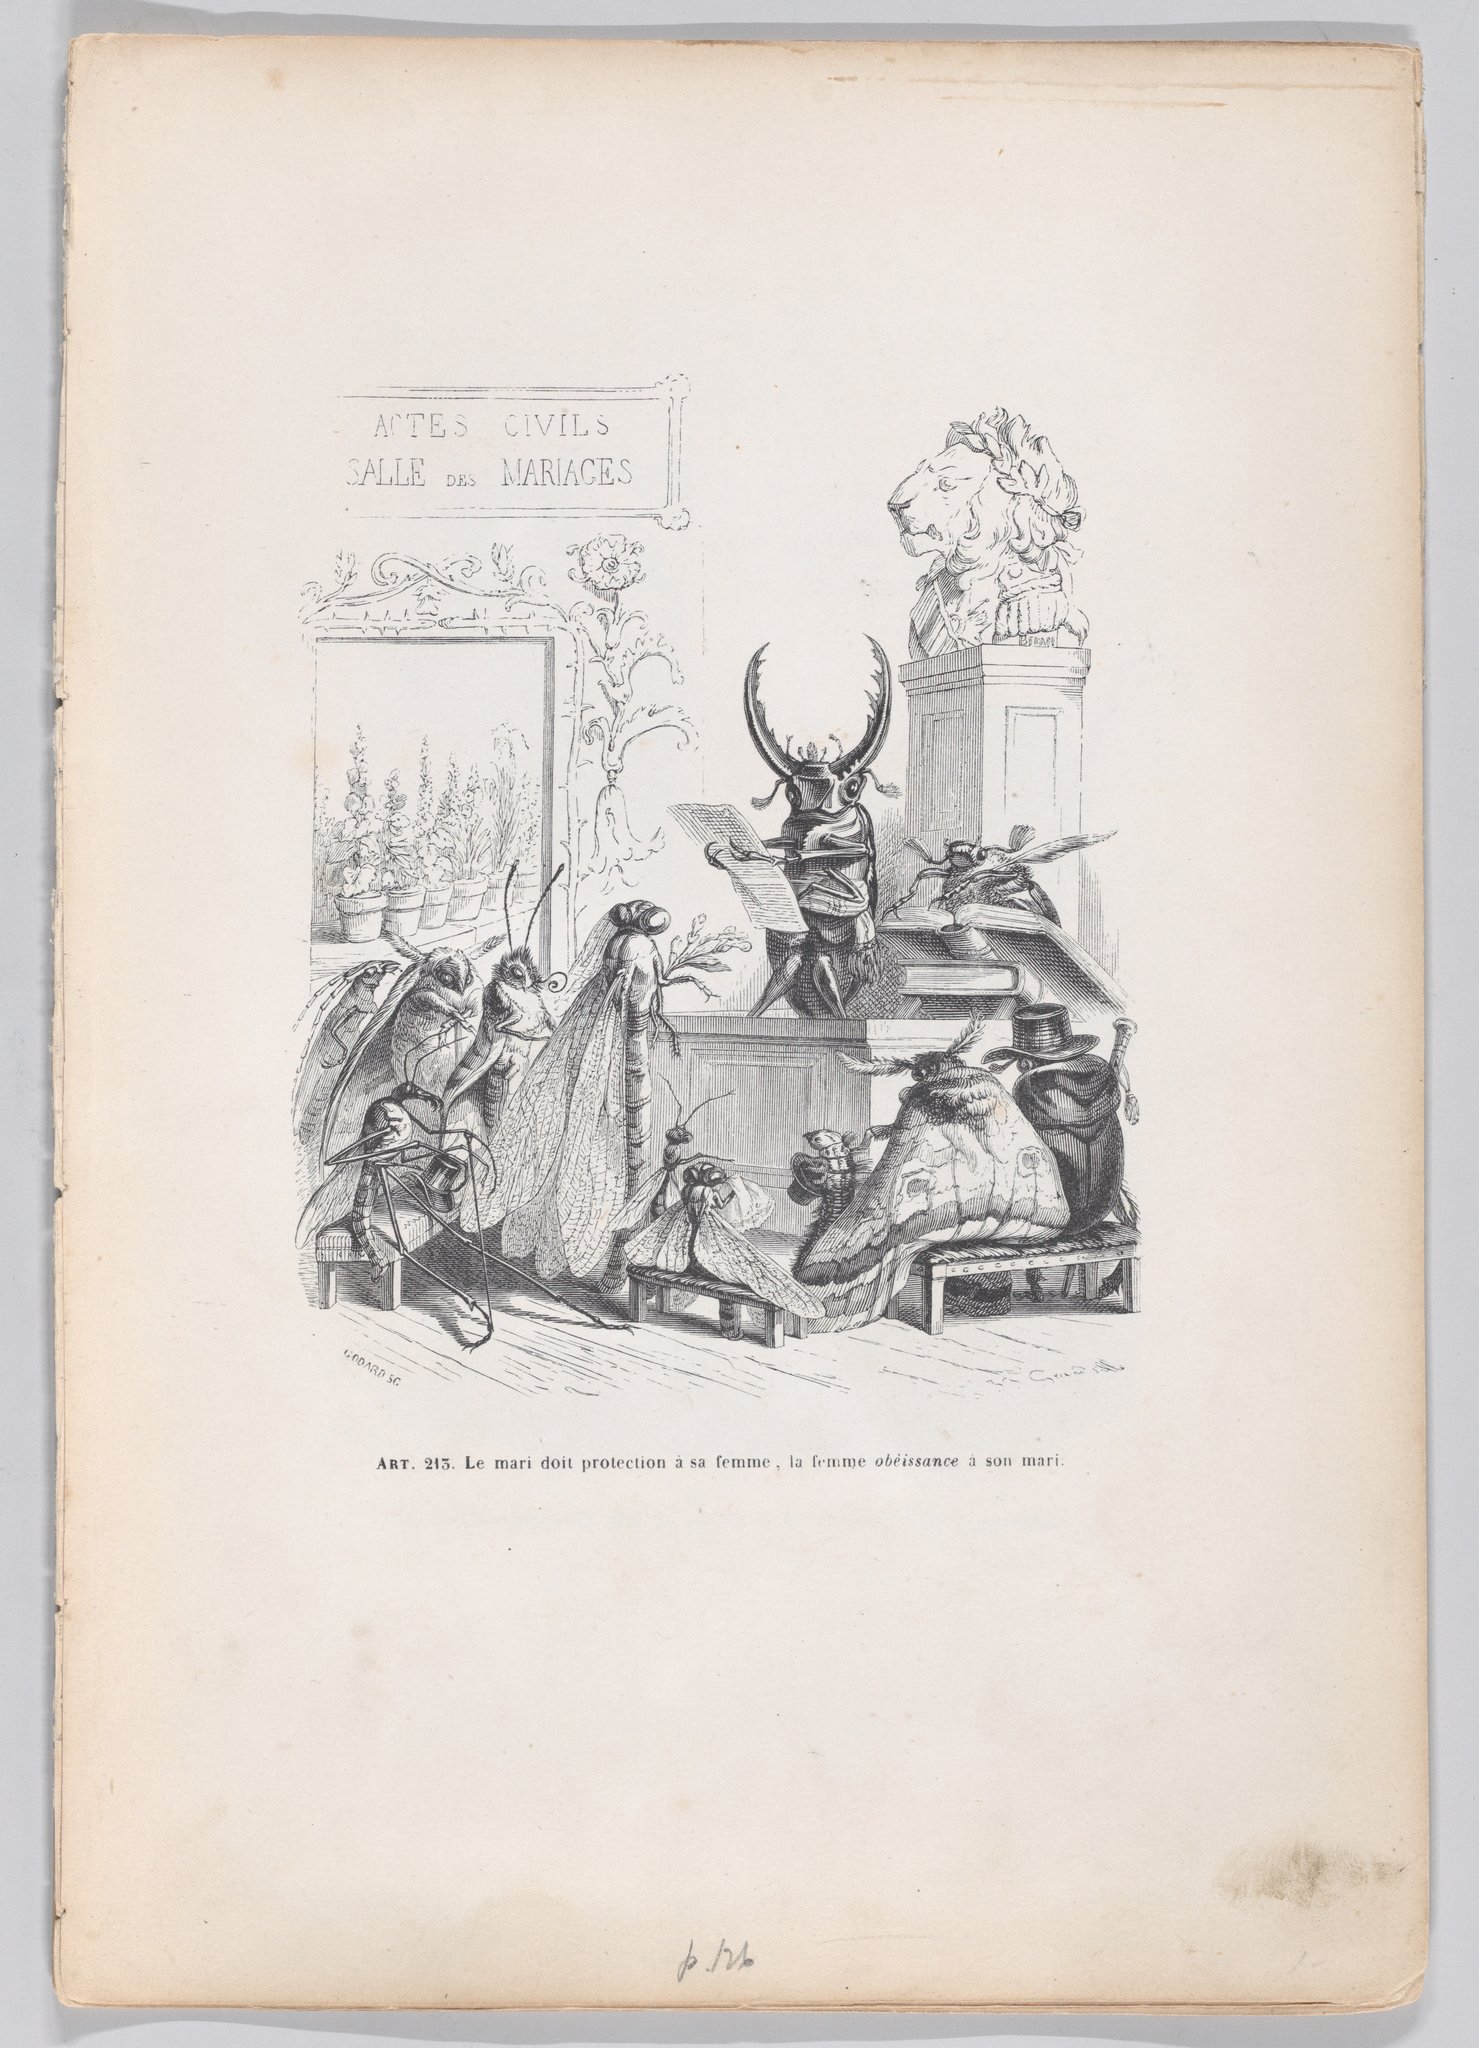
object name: print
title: Article 231. The husband needs to protect his wife, the wife needs to obey her husband, from "Scenes from the Private and Public Life of Animals"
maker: j. j. grandville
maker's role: illustrator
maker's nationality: french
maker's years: 1803-1847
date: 1837-1847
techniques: engraving